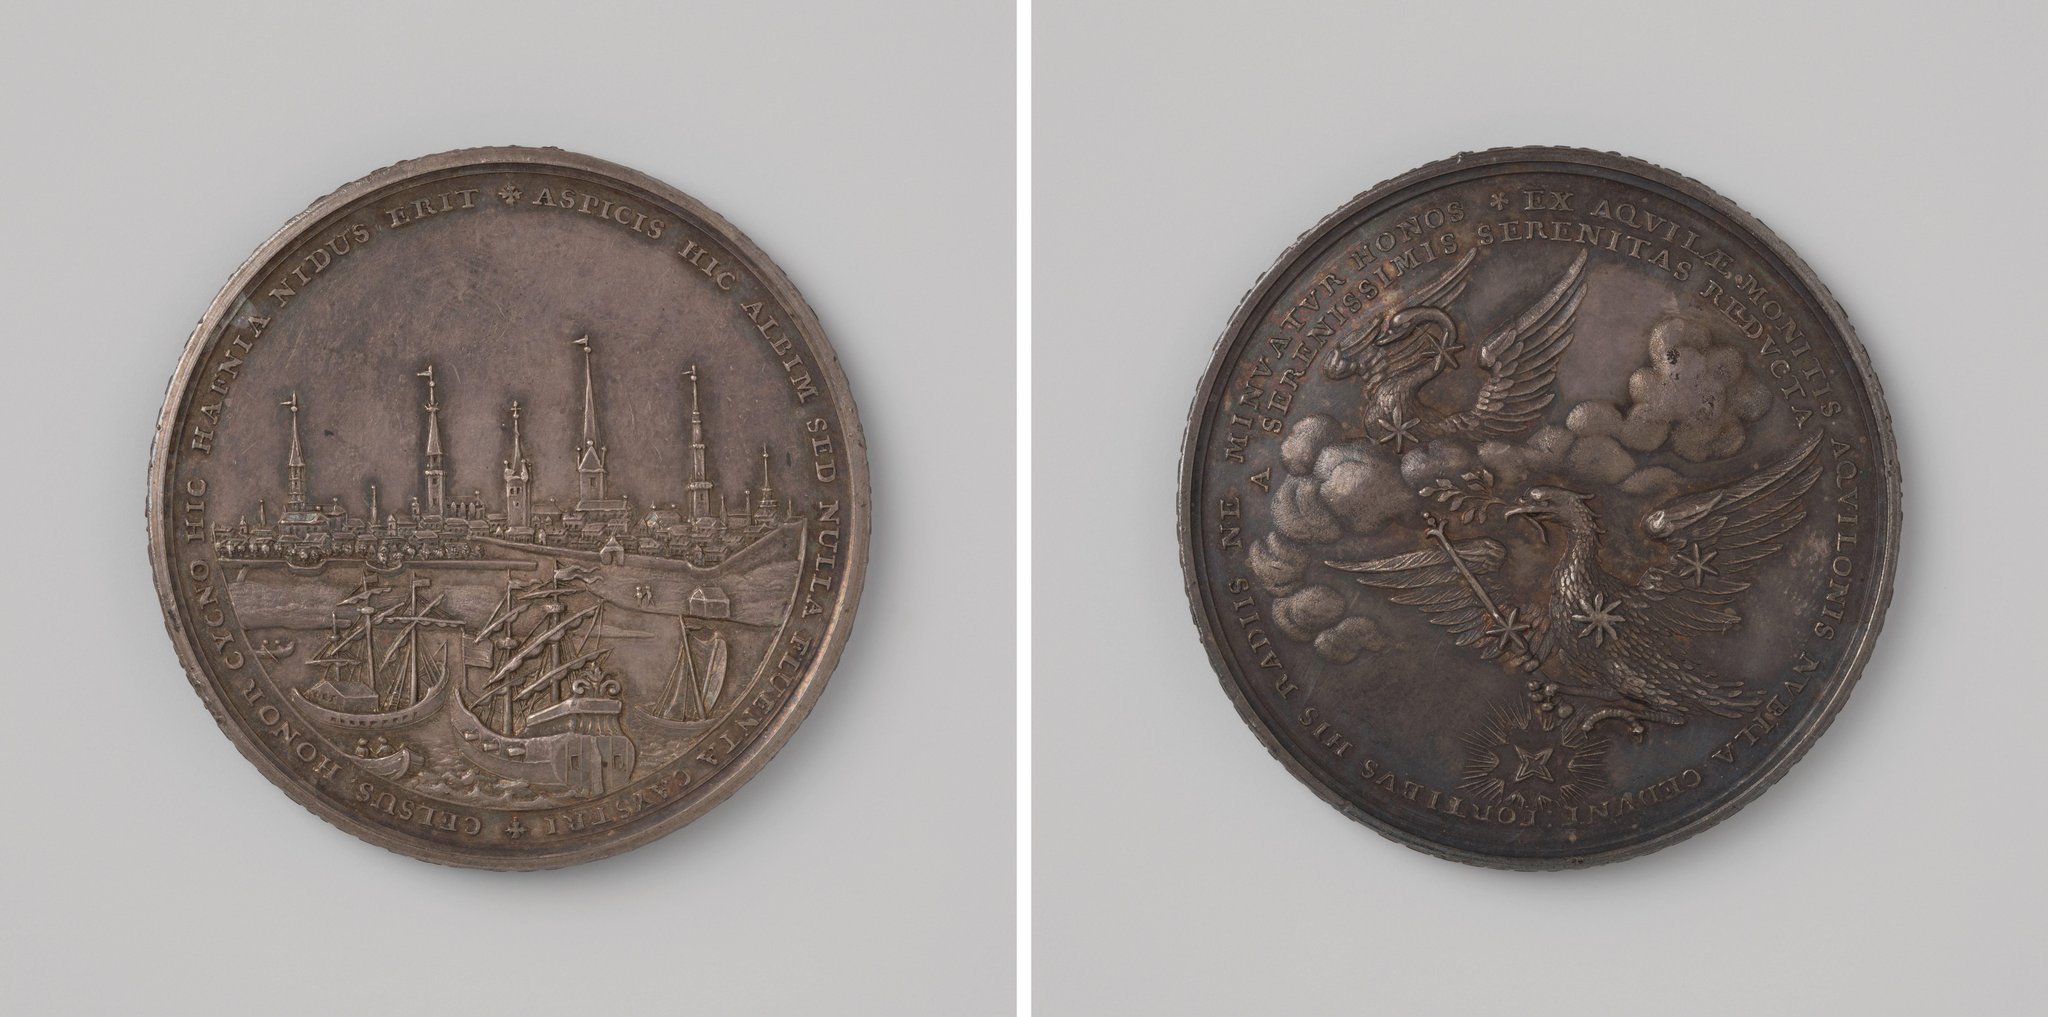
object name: history medal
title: Mislukte belegering van Hamburg door de koning van Denemarken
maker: Anonymous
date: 1686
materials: silver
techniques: striking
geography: germany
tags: copenhagen (city)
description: Zilveren penning. Voorzijde: gezicht op stad Hamburg aan haven binnen omschrift. Keerzijde: arend met ster, olijftak en scepter en zwaan met ster in wolken binnen omschrift; randschrift